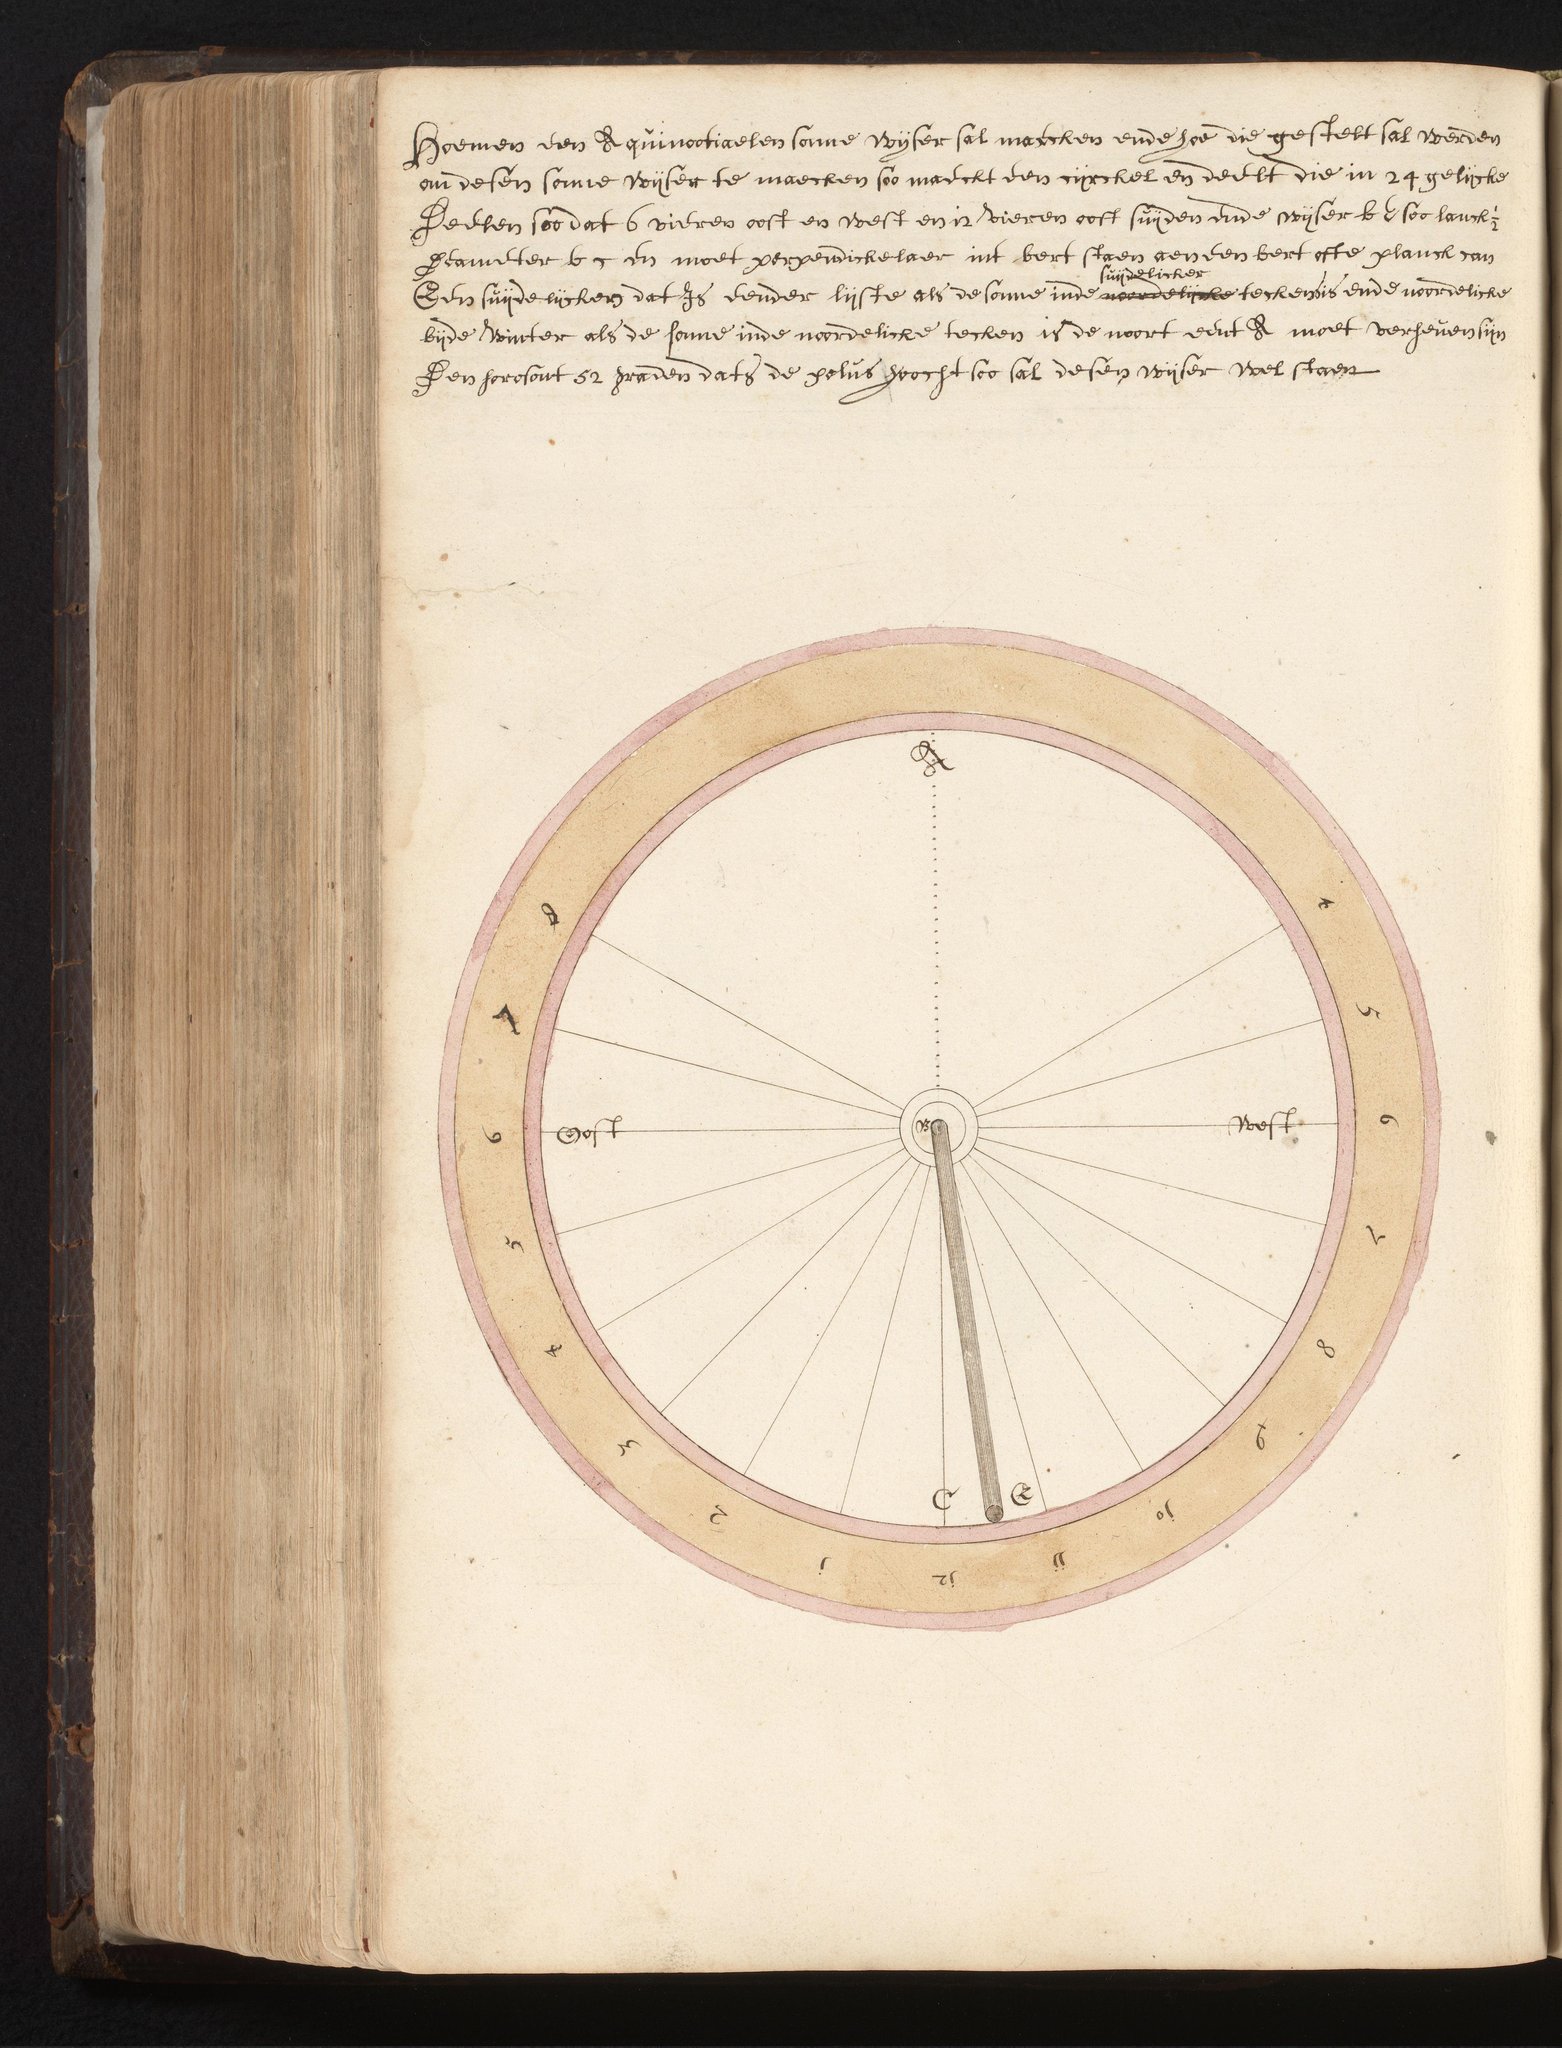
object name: drawing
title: Ontwerp voor een zonnewijzer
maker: Anonymous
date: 1650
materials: ink, paper, pencil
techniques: brush, pen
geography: low countries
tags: sundial